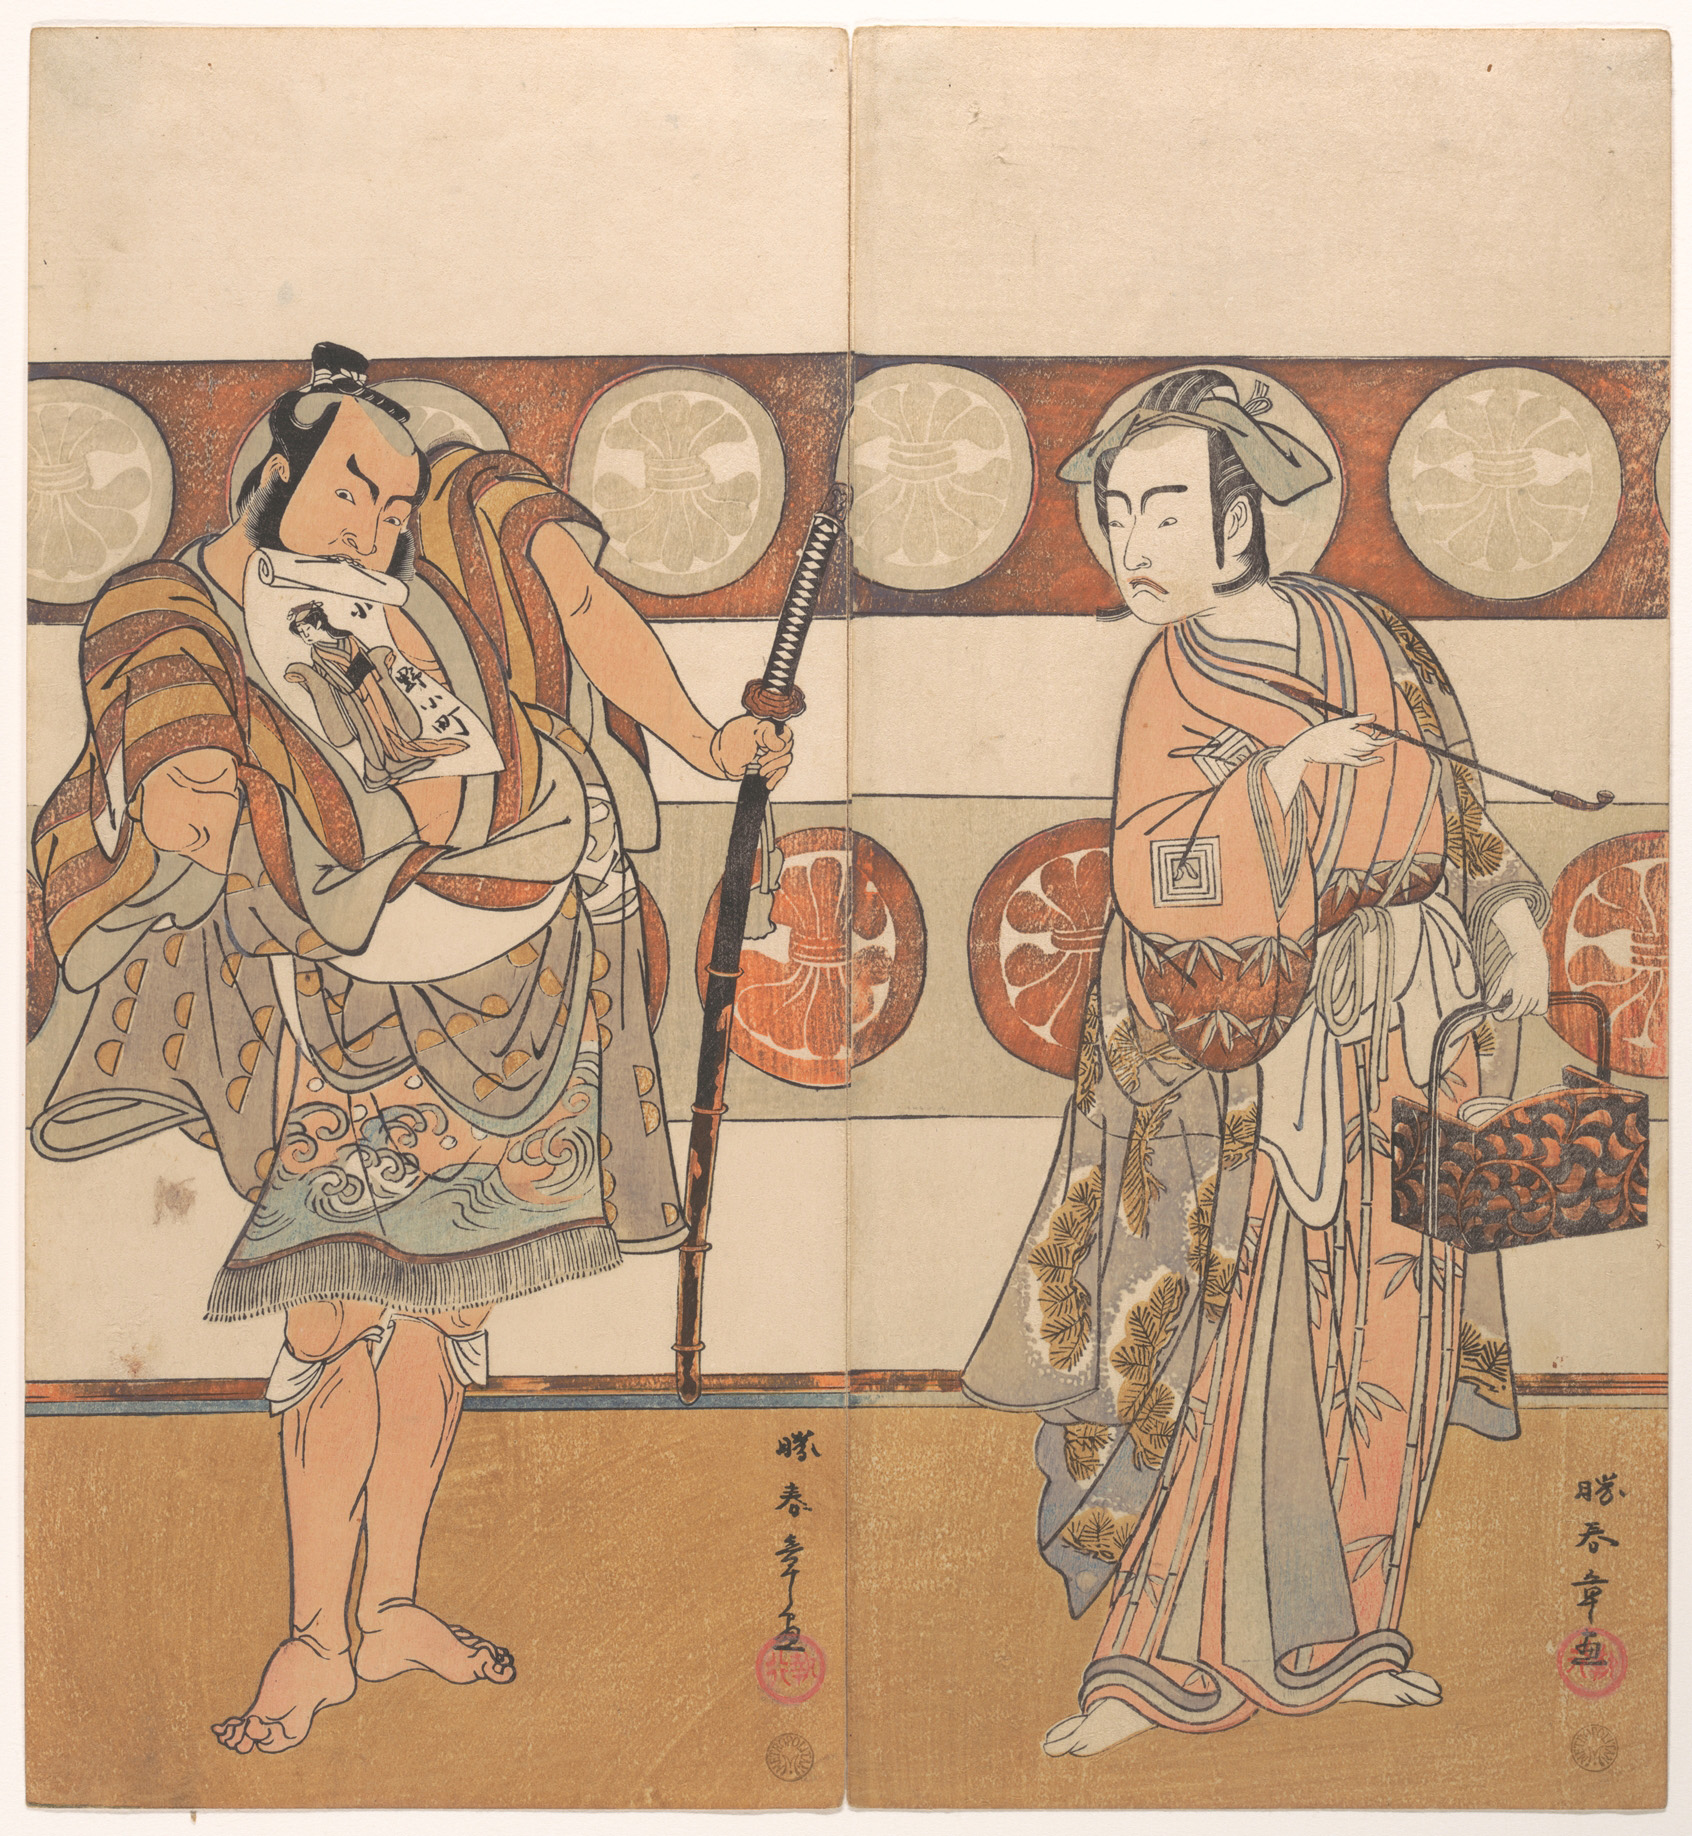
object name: woodblock print nishiki e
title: The Actors Ichikawa Yaozo III and Nakamura Sukegoro II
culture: japanese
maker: katsukawa shunshō 勝川春章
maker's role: artist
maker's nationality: japanese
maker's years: 1726-1792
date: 1791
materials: ink, paper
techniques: nishiki e, woodblock print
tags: swords,men,actors